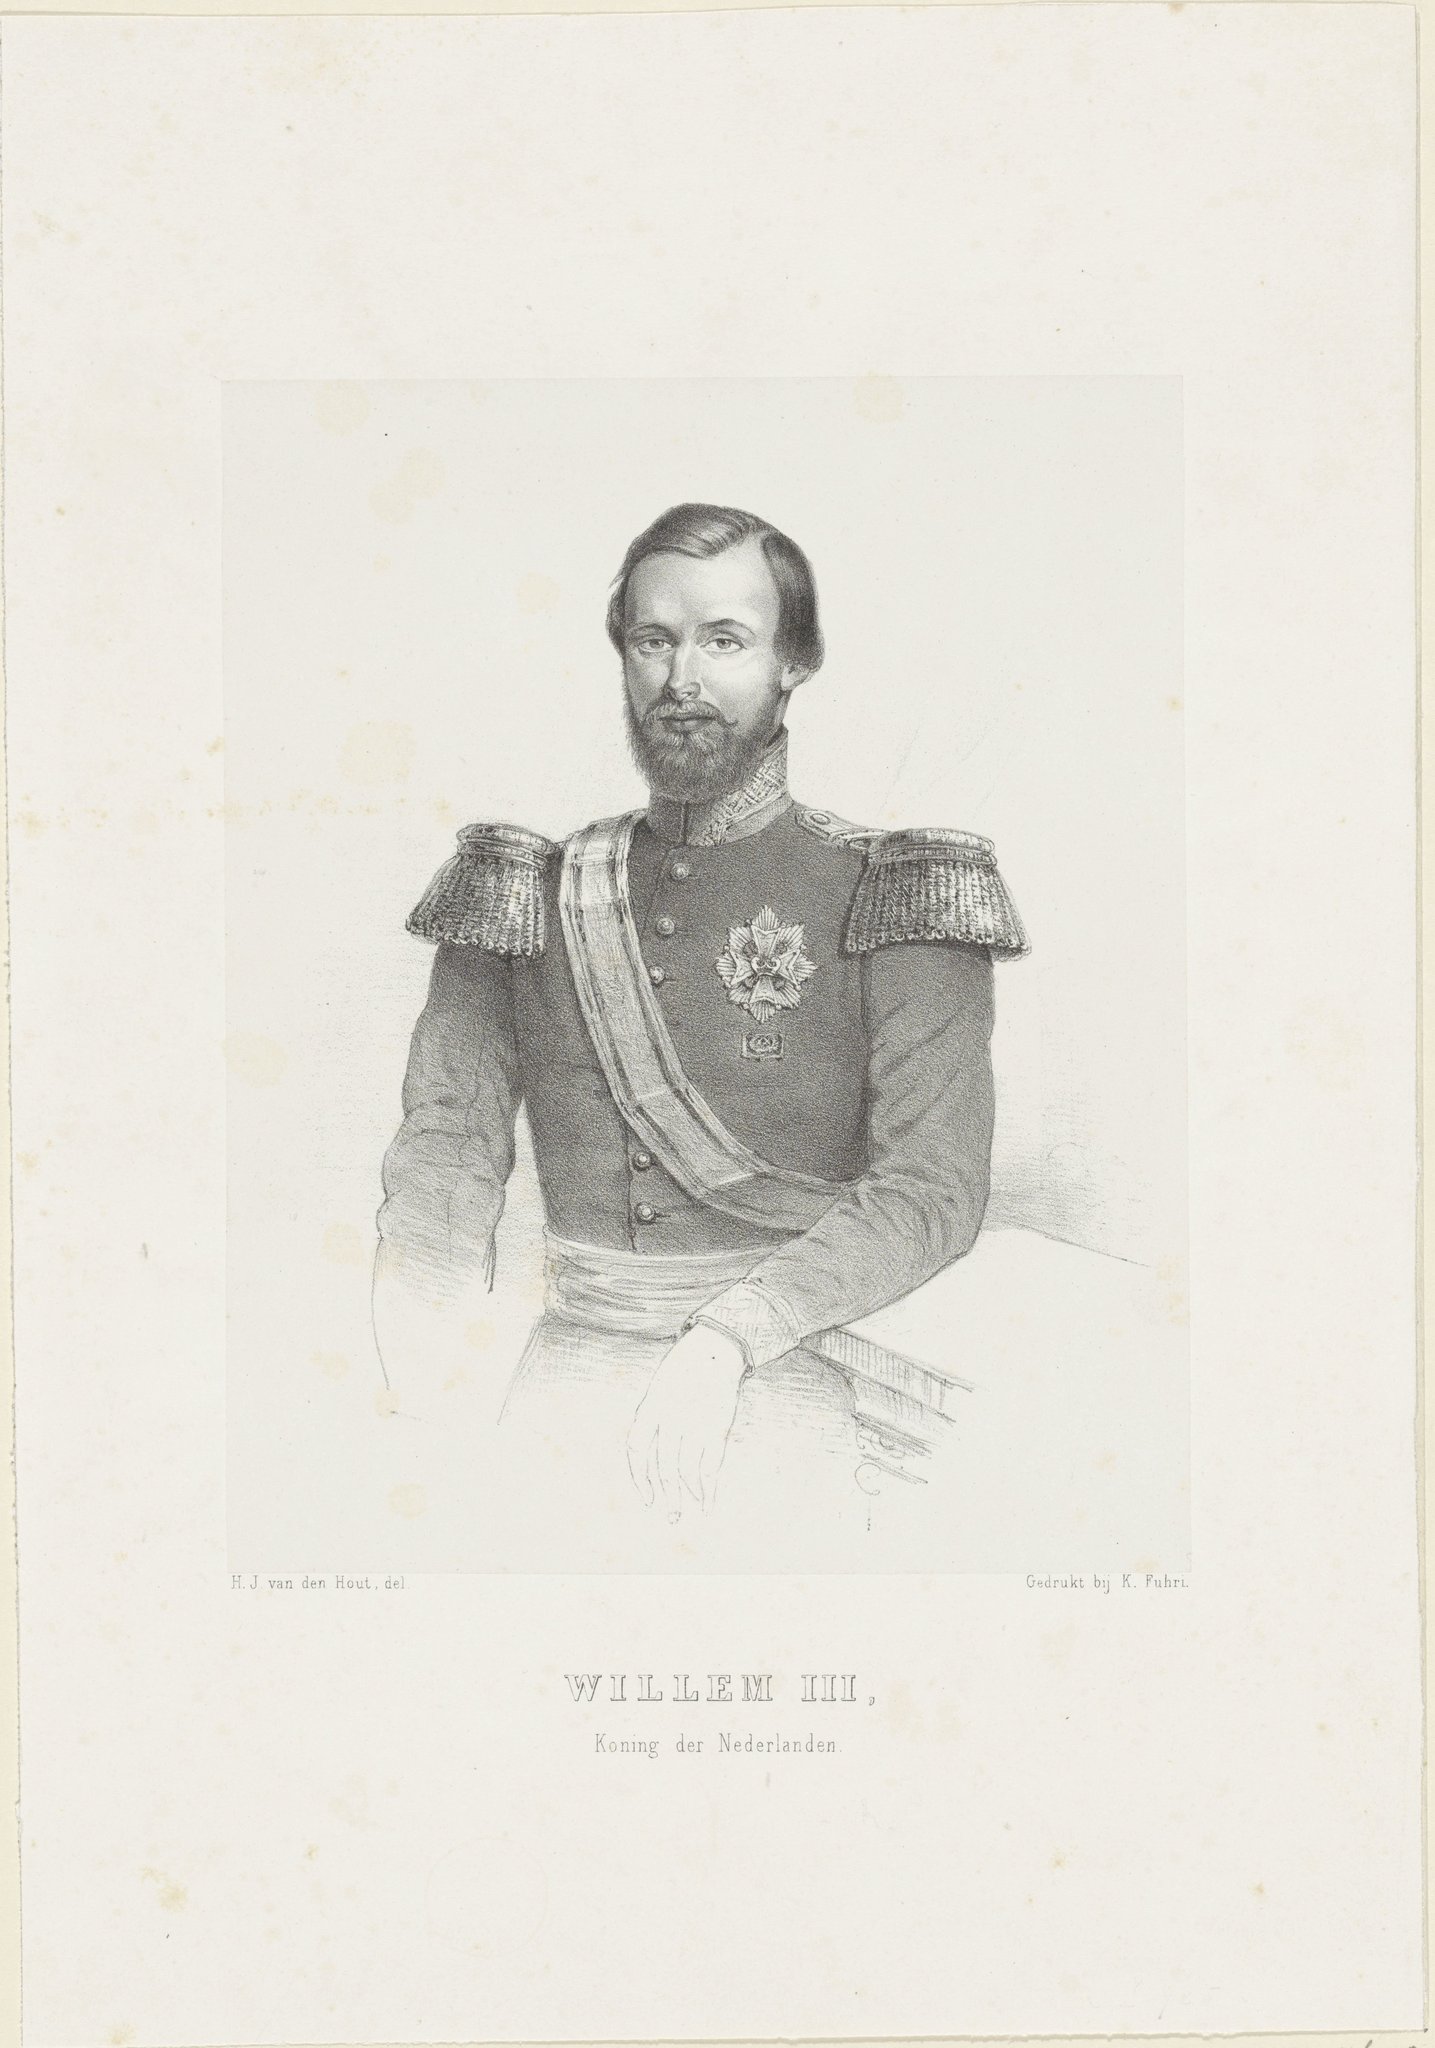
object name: print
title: Portret van Willem III, koning der Nederlanden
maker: koenraad fuhri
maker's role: bookseller, printer, publisher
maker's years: 1814-1858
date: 1849-1853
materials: paper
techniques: lithograph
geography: the hague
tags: brussels, willem iii (koning der nederlanden)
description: De hier vermelde titel verwijst naar de hoogst verkregen titel van de geportretteerde, niet per se naar de titel die de geportretteerde op deze voorstelling draagt.